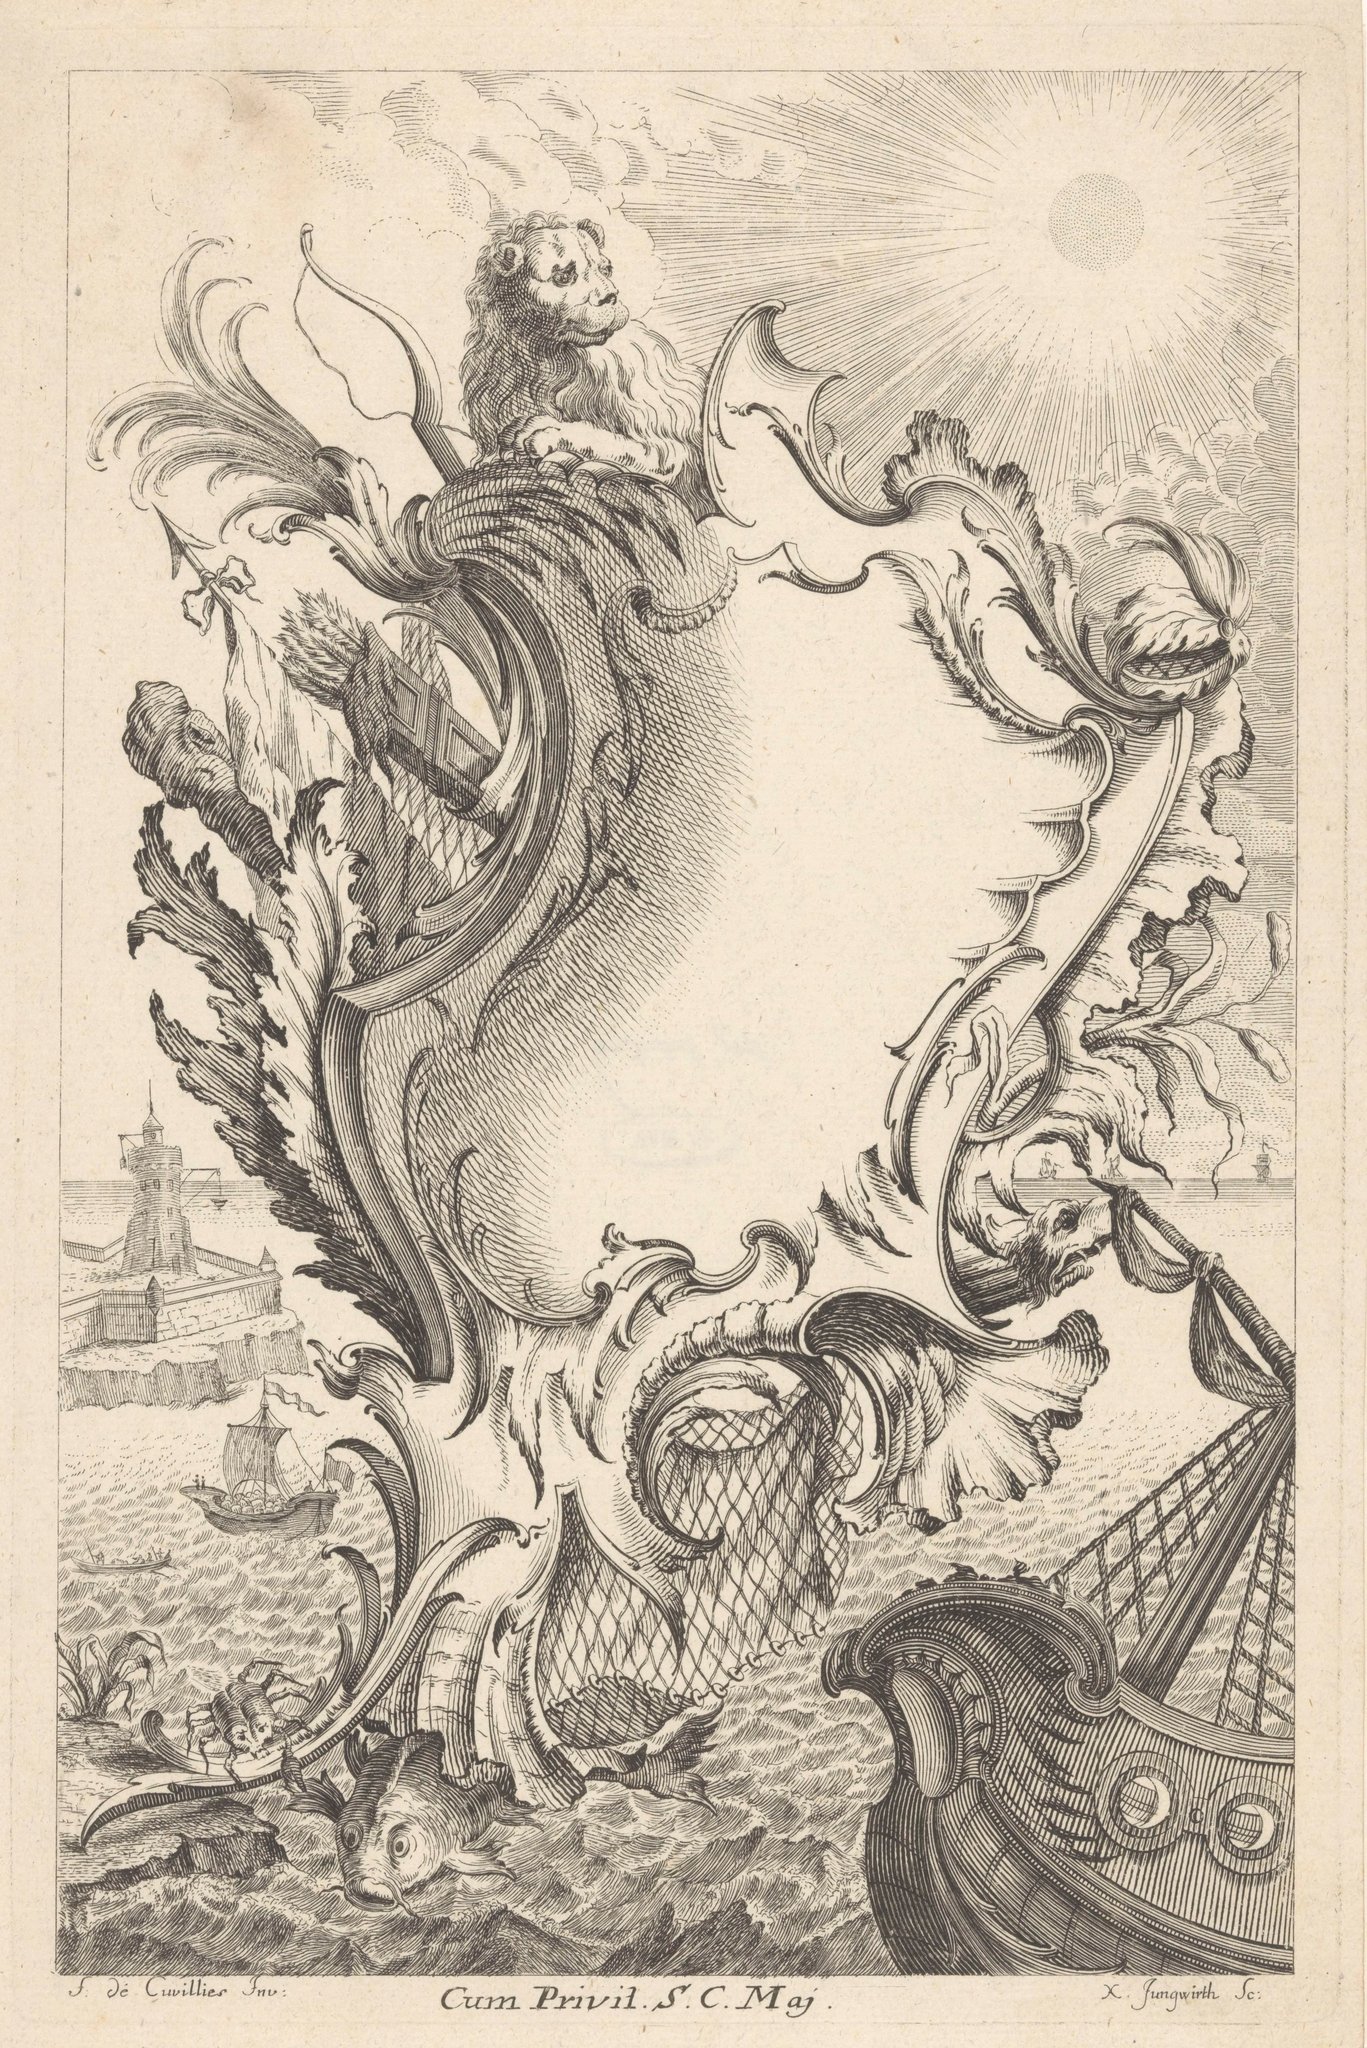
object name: print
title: Cartouche met leeuw en wapens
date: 1738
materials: paper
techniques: etching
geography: germany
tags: ships (in general), weapons, sea (seascape), ornament ~ cartouche, beasts of prey, predatory animals: lion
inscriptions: collector's mark: Lugt 2228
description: Een cartouche met een leeuw en wapens in een zeelandschap met aan de onderzijde visnetten, zeedieren en een boot. In de achtergrond schepen en een vuurtoren.